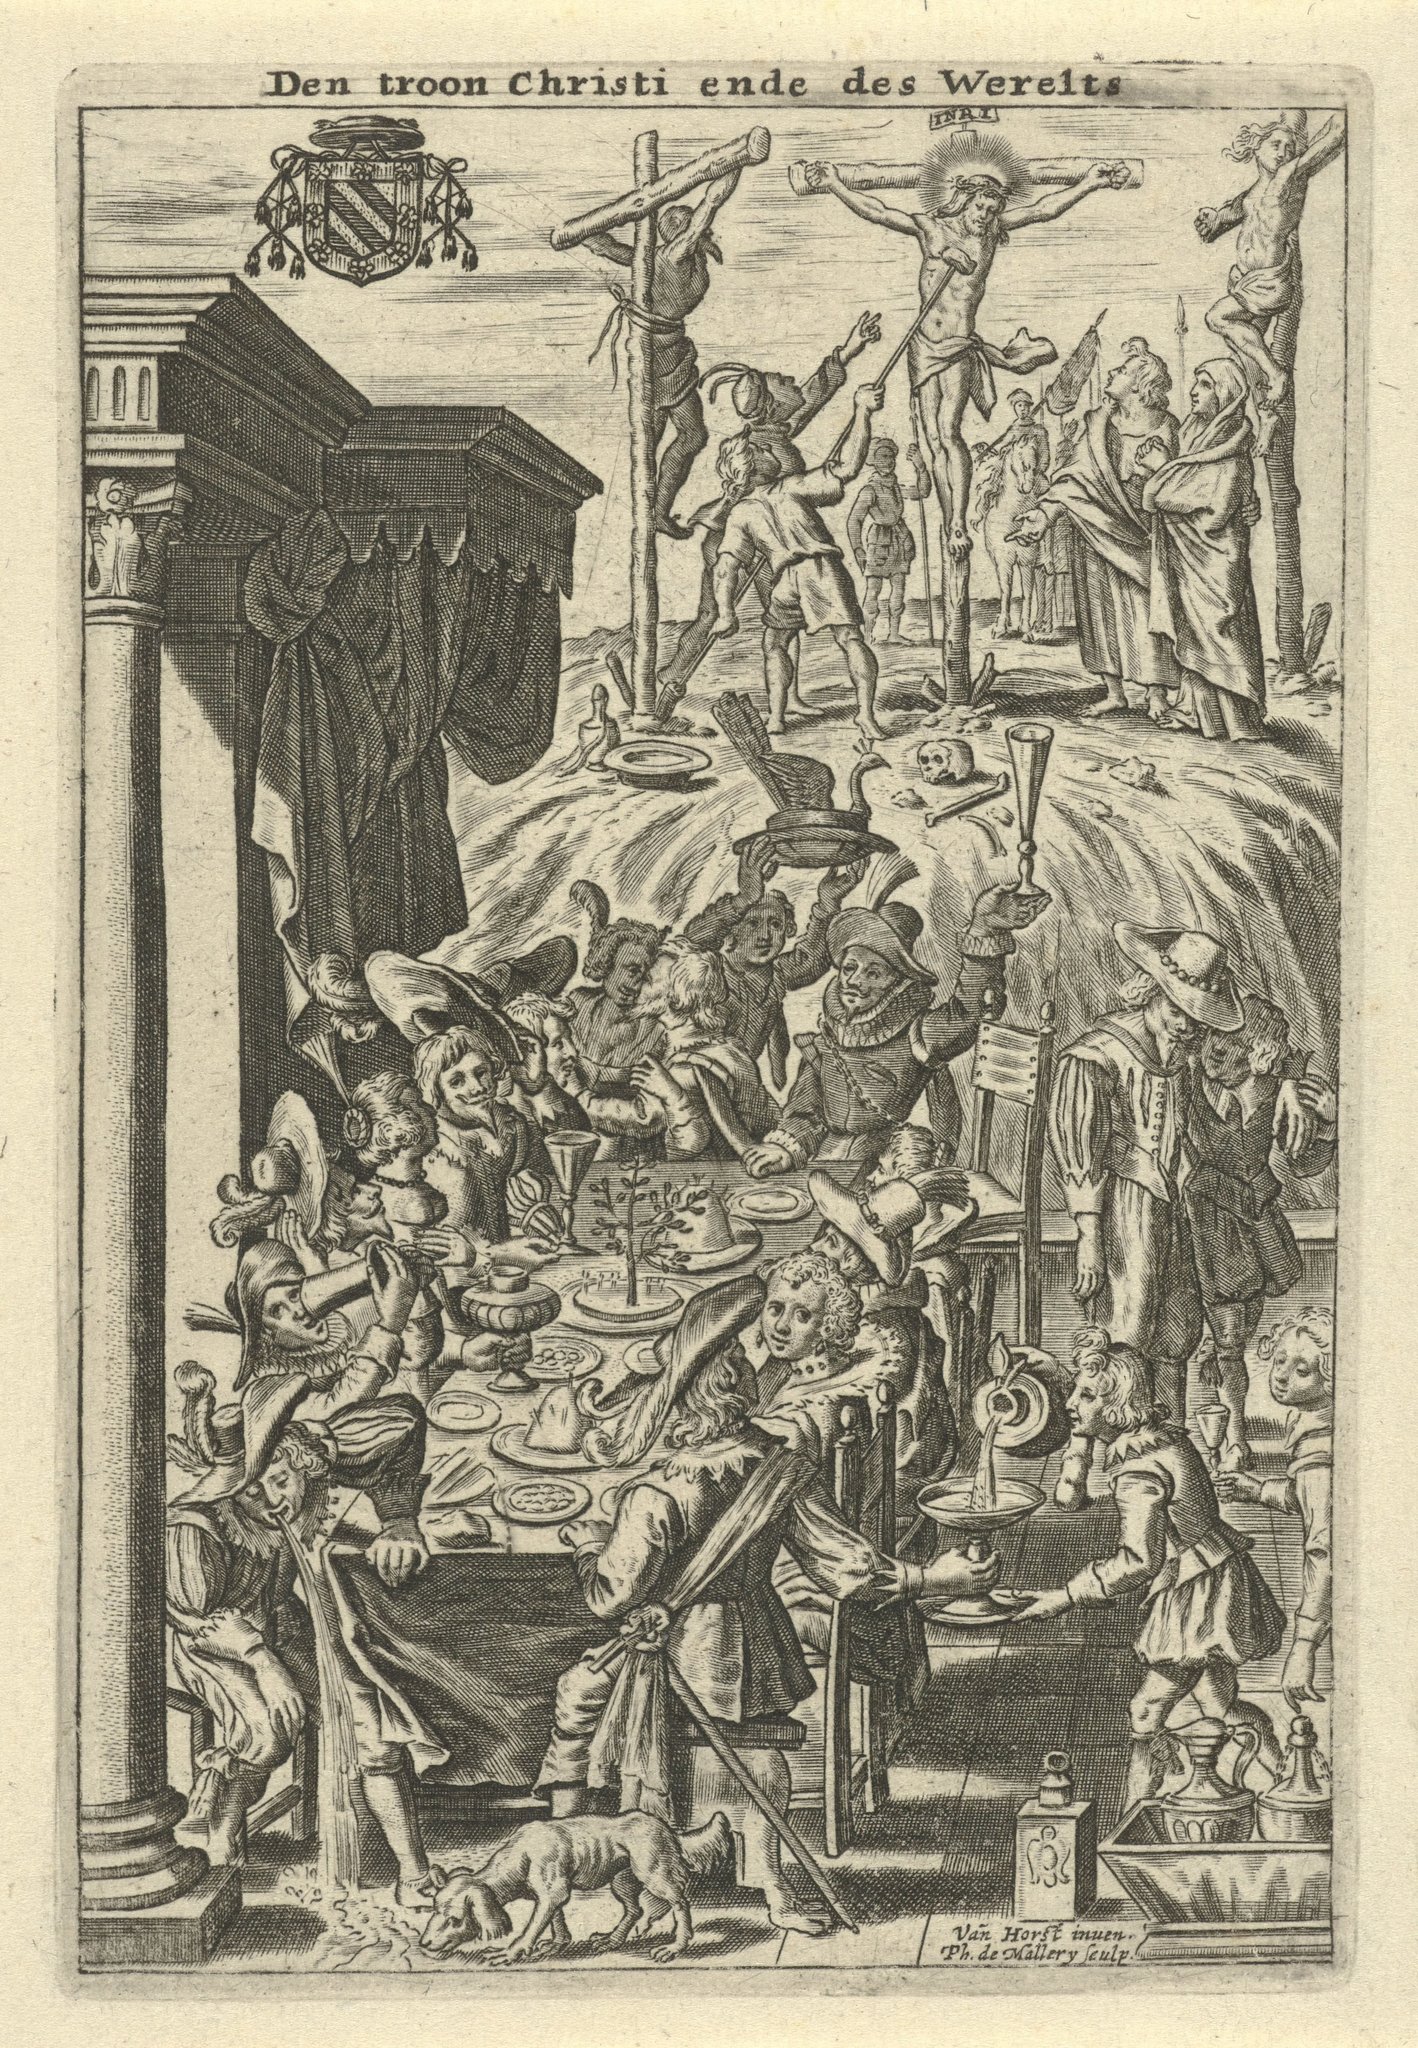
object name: print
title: Moraliserende lessen voor hovelingen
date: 1630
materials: paper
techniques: engraving, etching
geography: antwerp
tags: crucified christ with mary, john, stephaton and longinus - dd - the three crosses, banquet of elegant company, festivities (+ eating and drinking ~ festive activities)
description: Vele mooi aangeklede figuren aan een gastmaal, onder een baldakijn, bij een klassiek bouwsel. Er wordt veel gedronken, bedienden schenken glazen vol en een hond likt aan het braaksel van een man op de voorgrond. Op de achtergrond Golgotha, waar Christus aan het kruis een in azijn gedrenkte spons krijgt aangeboden. Onder het kruis Maria en Johannes en aan weerszijden van Christus de twee eveneens gekruisigde misdadigers. Linksboven een kerkelijk wapen en bovenaan de titel in een regel in het Nederlands. Prent uit een boekuitgave waarin steeds een scène uit het leven van Christus tegenover een wereldse situatie is gesteld.